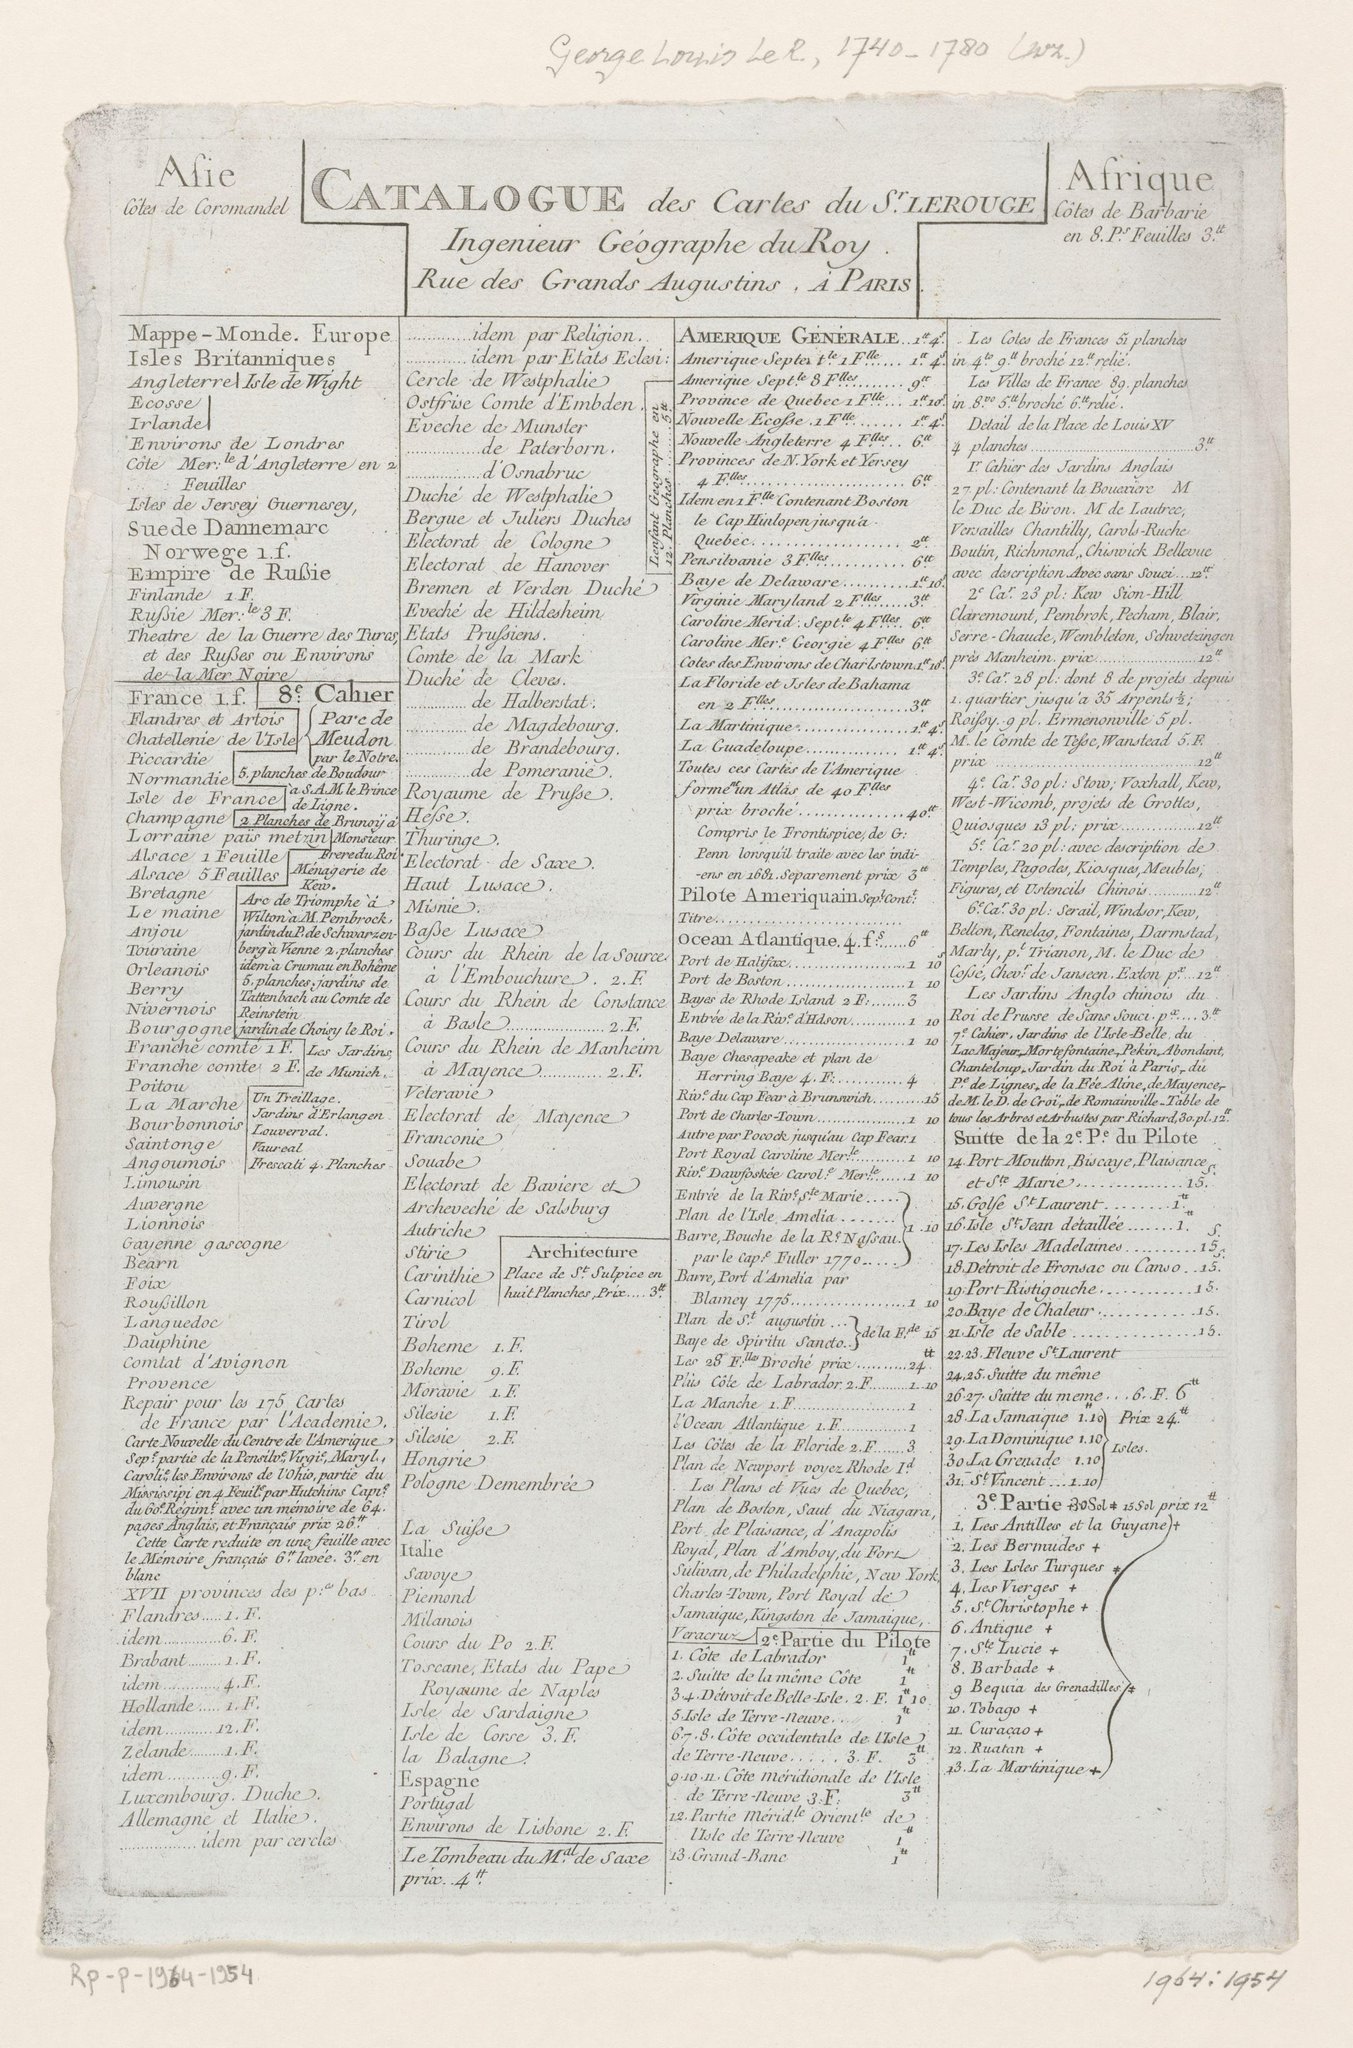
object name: text sheet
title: Catalogue des cartes du Sr. Lerouge ingenieur géographe du Roy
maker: Anonymous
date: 1780-1785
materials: paper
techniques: engraving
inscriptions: collector's mark: Lugt 2228